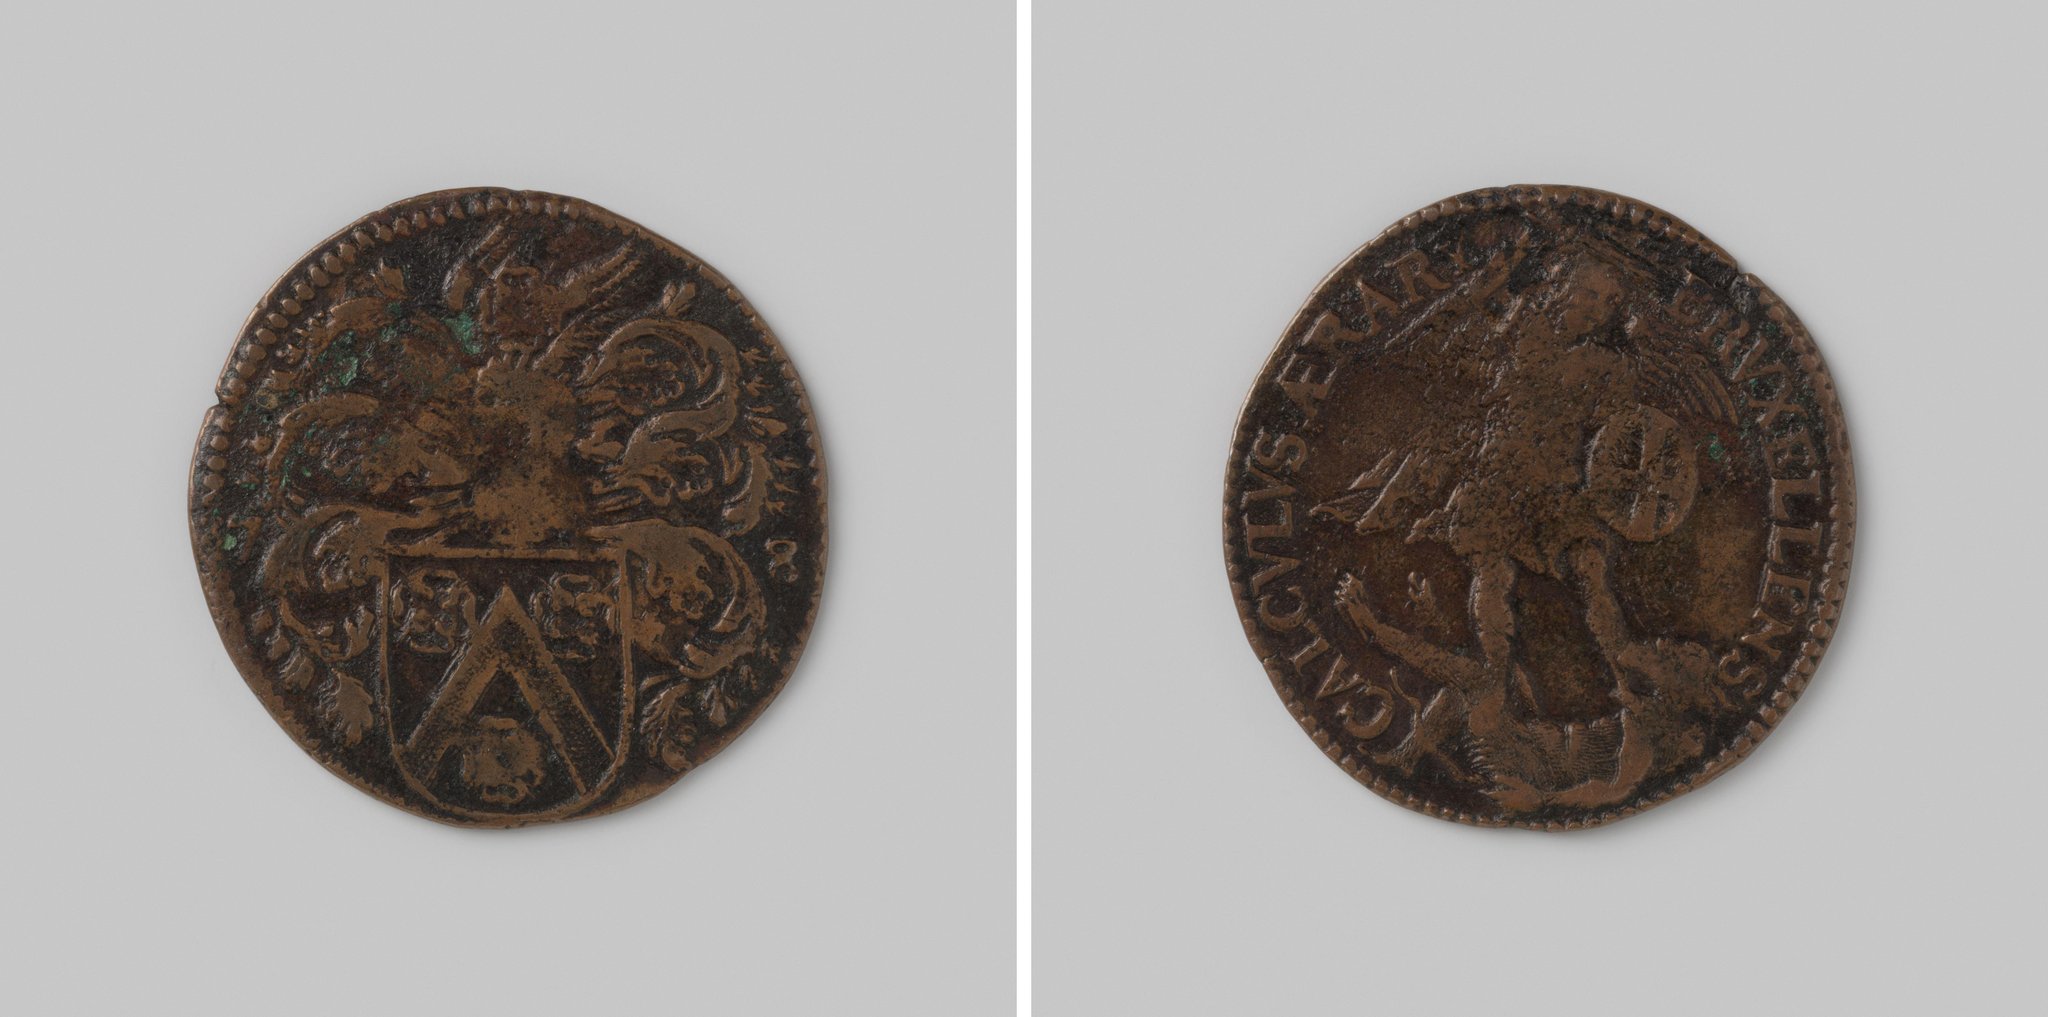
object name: history medal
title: Rekenpenning uit Brussel voor J. Heijmans tresorier van Brussel 1678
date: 1678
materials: copper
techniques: striking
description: Koperen penning, op de voorzijde een gehelmd wapenschild, op de keerzijde een engel die een duivel verslaat, met omschrift.